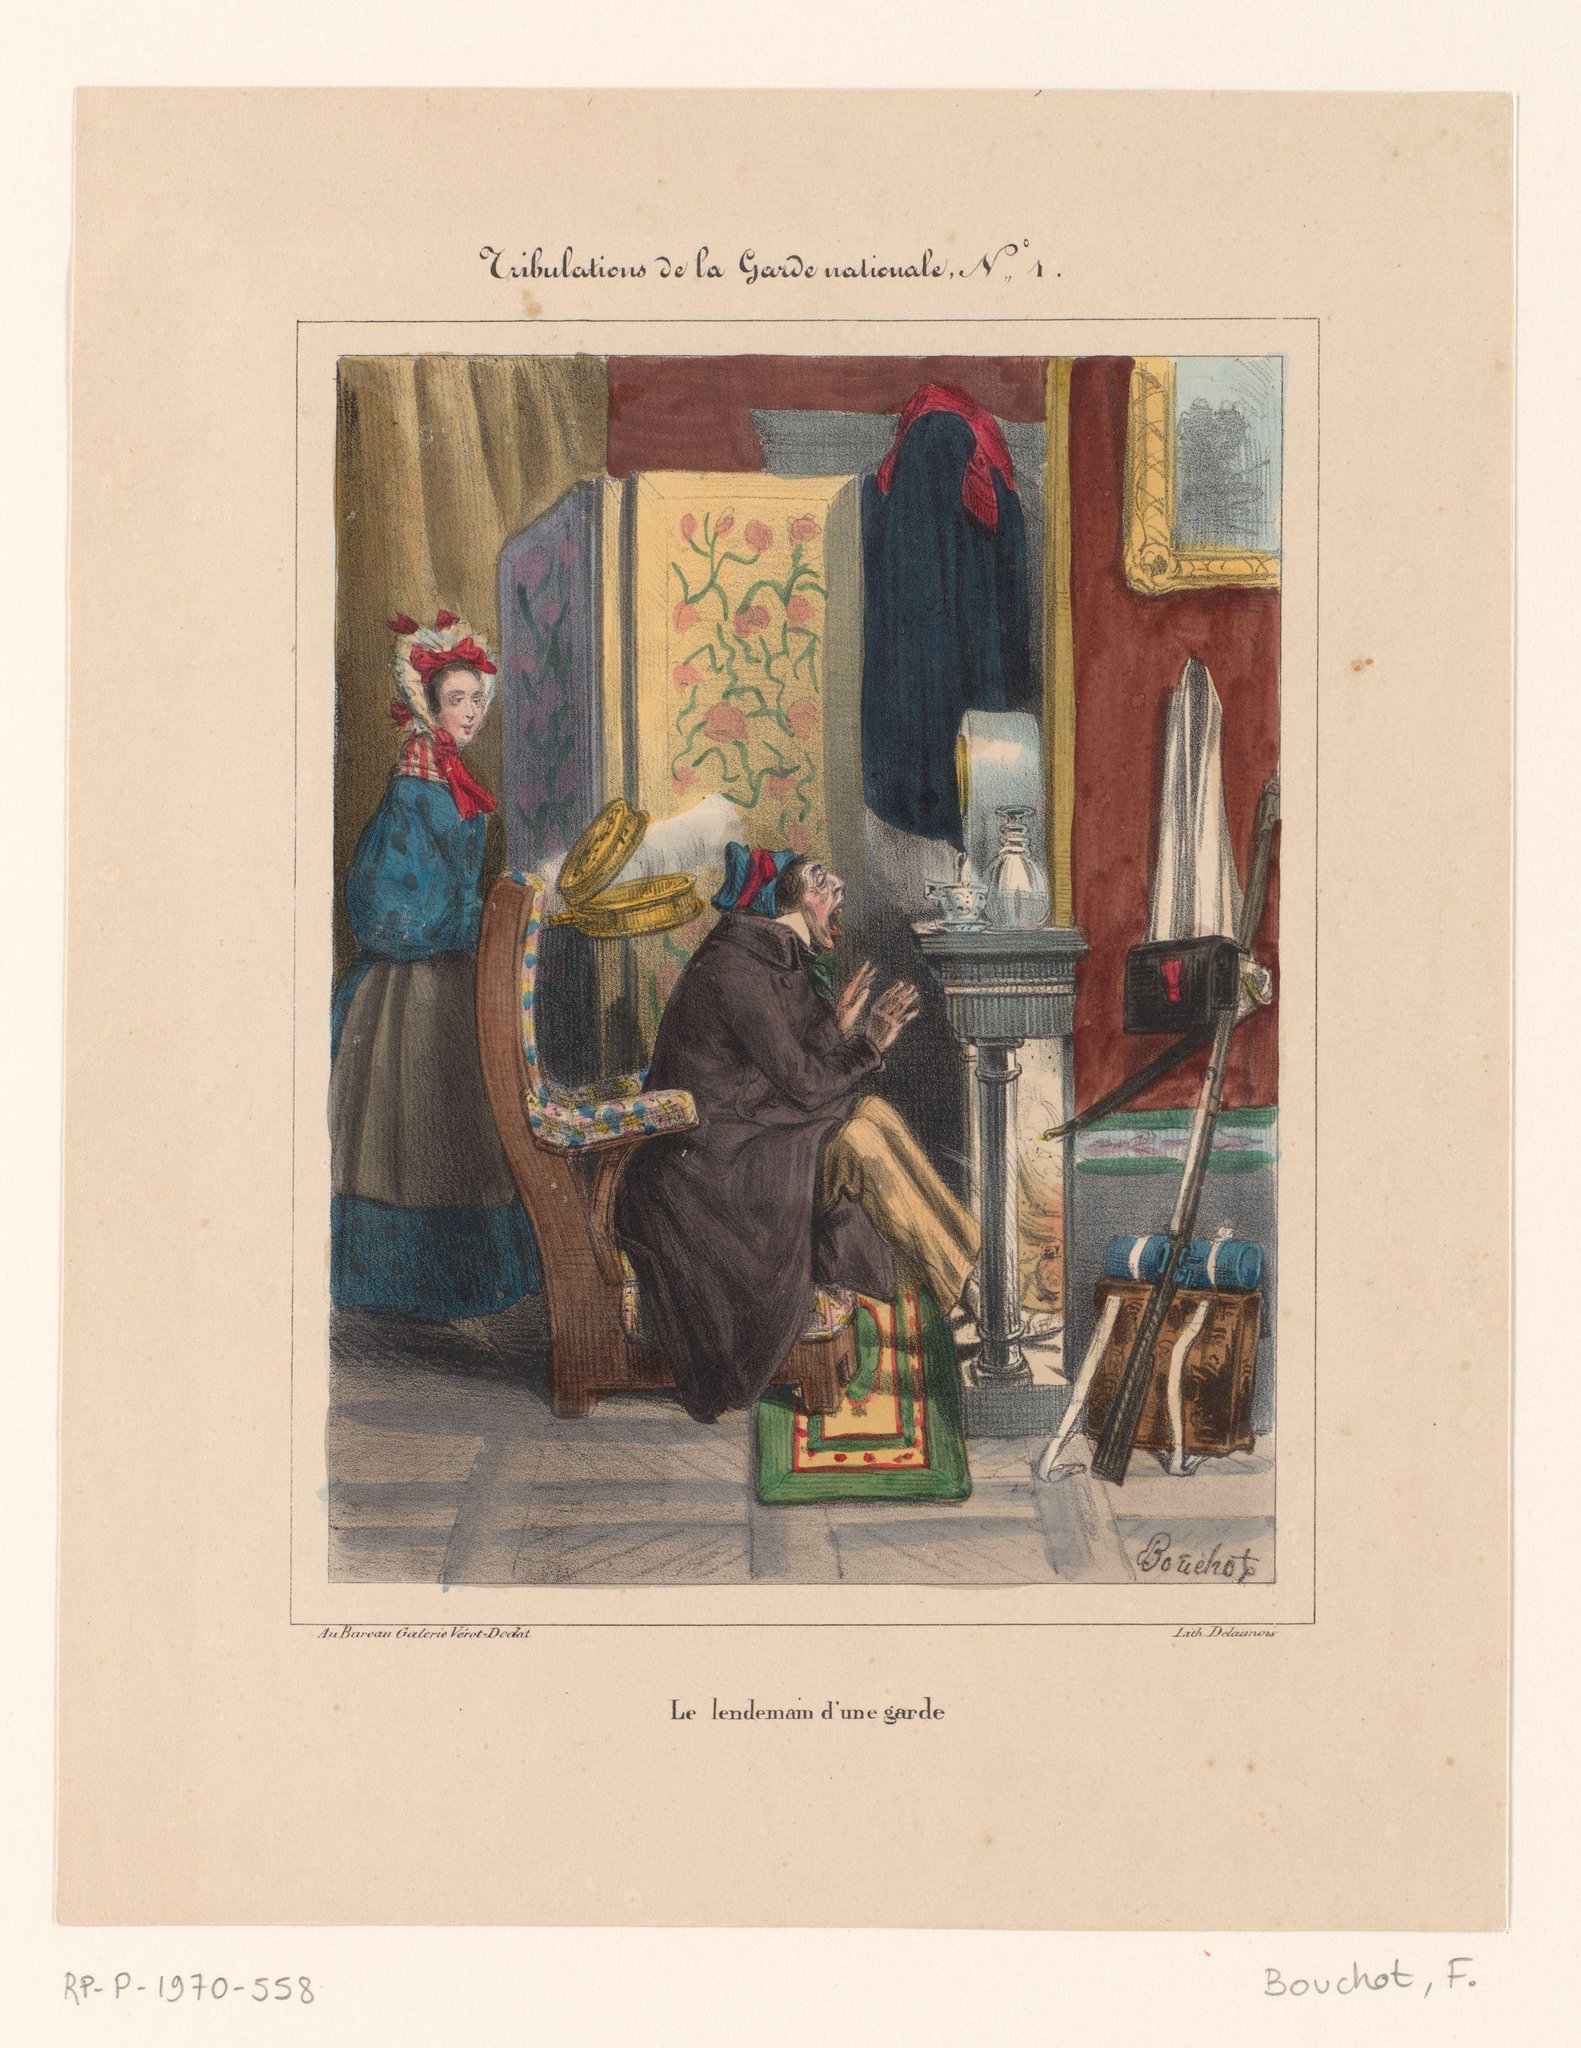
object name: print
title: Tribulations de la Garde nationale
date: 1835-1837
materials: paper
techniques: hand coloring, lithograph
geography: paris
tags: the soldier off duty, hearth and stove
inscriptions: collector's mark: Lugt 2228a, annotation: ‘v. Stockum, 24 nov. 1964, no. 172 (81 st.), f. 520,-’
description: Nadat hij 's nachts de wacht heeft gehouden, warmt een lid van de Nationale Garde thuis zijn handen bij het haardvuur. Zijn vrouw loopt langs met een beddenpan.